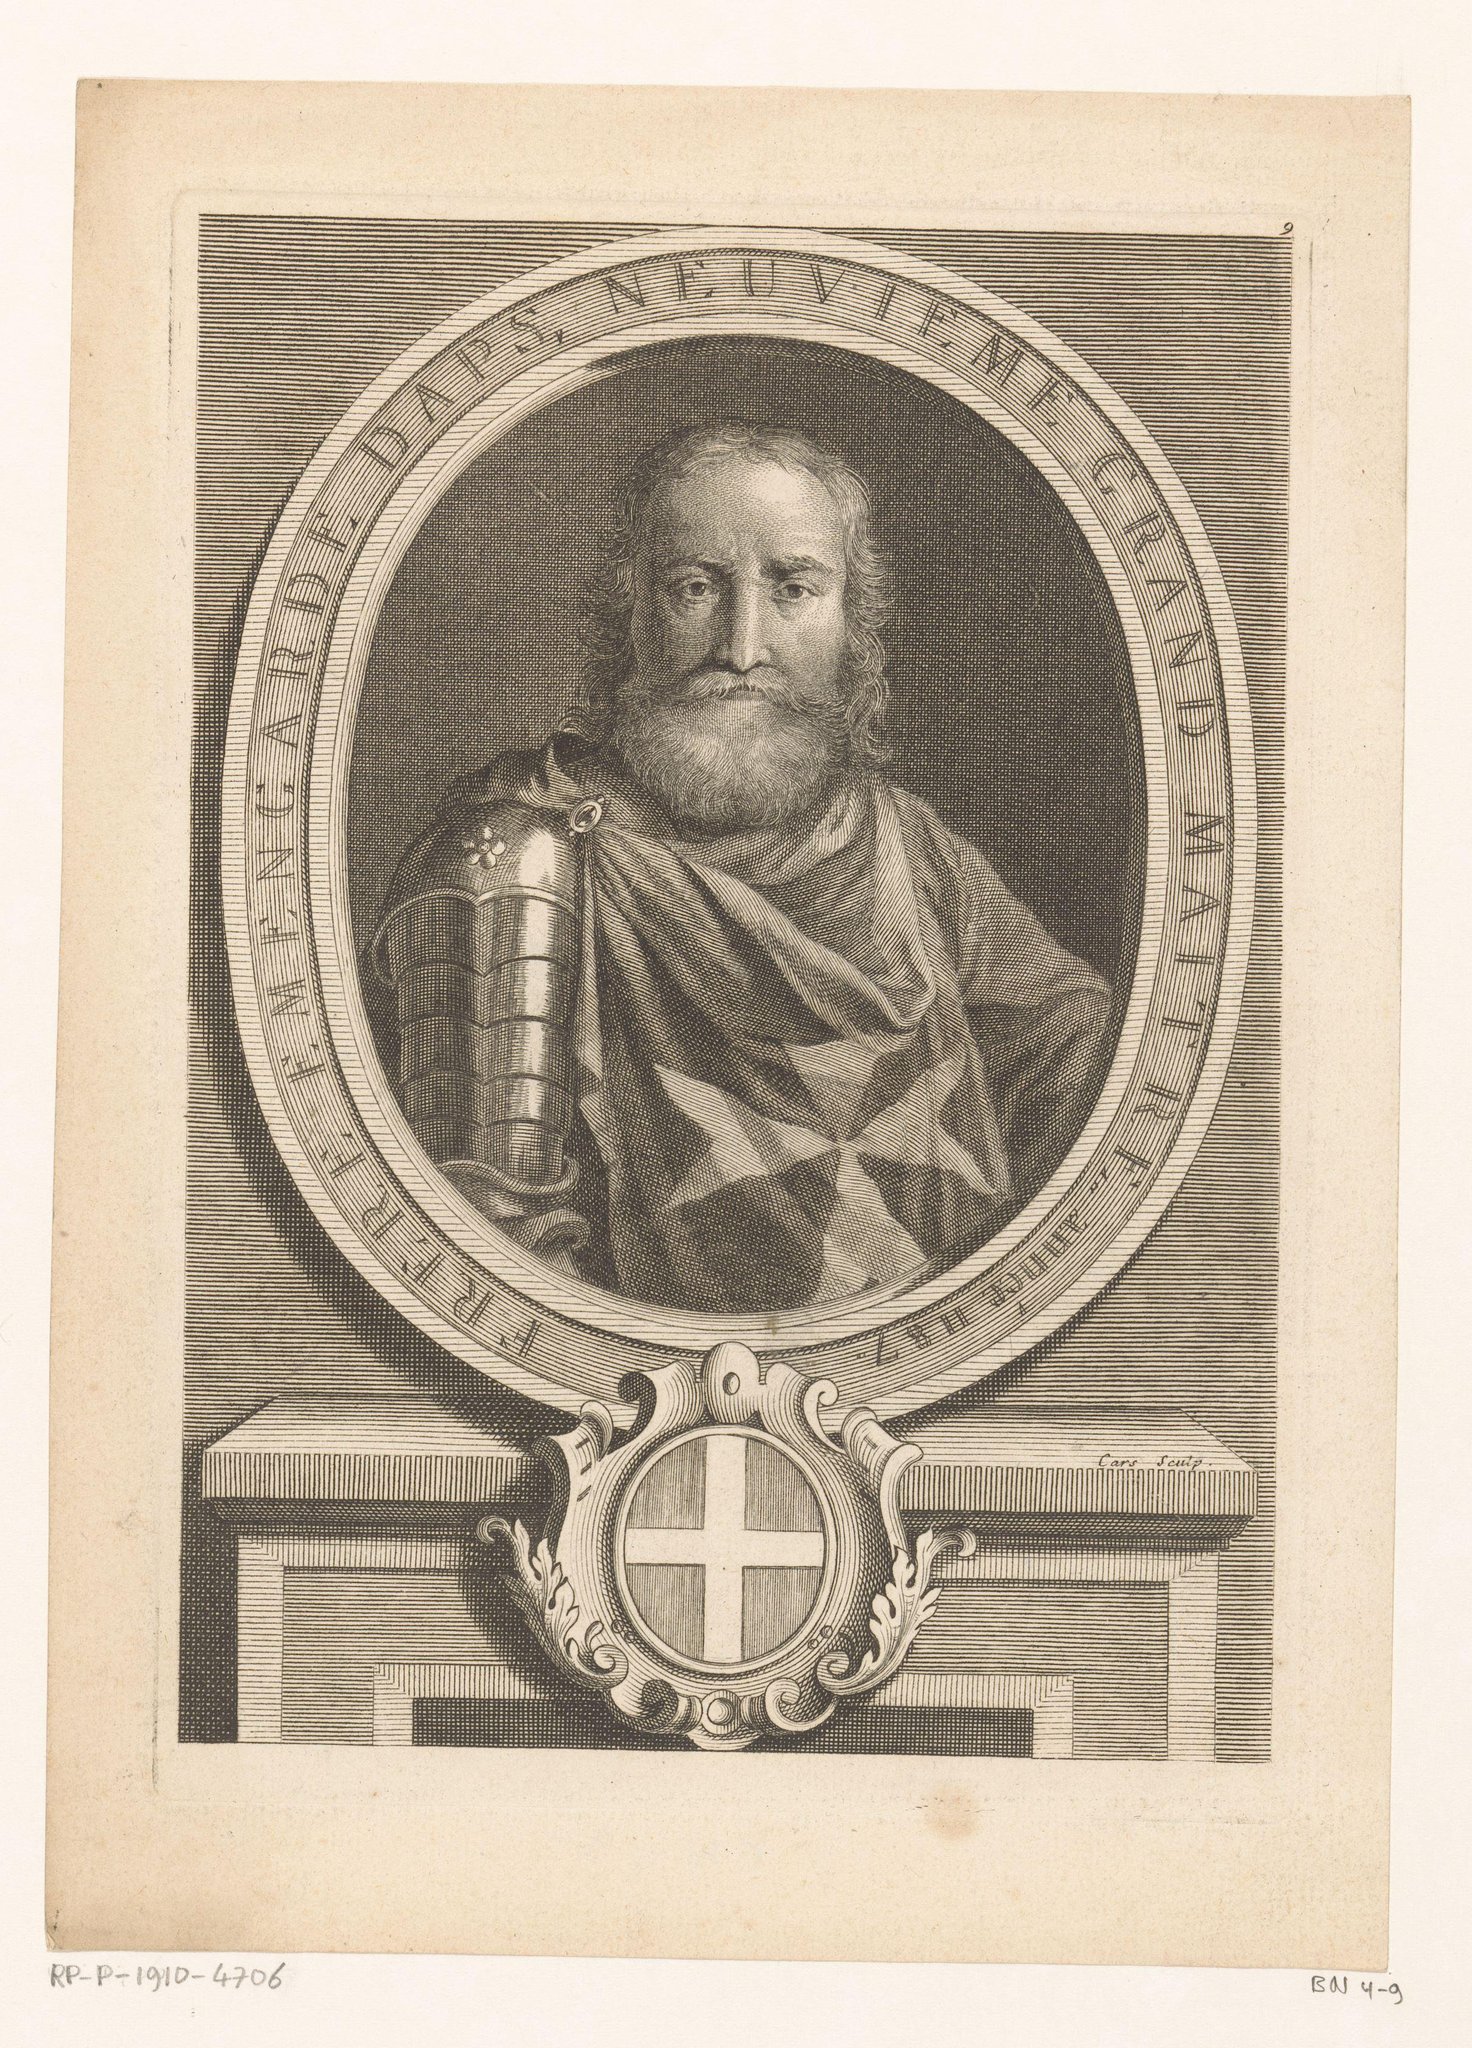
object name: book illustration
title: Portret van Hermangard d'Asp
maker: laurent cars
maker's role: print maker, publisher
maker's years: 1699-1771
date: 1726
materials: paper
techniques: engraving, etching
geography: france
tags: historical persons, military orders, e.g.: knights templars, knights of malta, teutonic knights ~ roman catholic church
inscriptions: collector's mark: Lugt 2228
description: Prent uit: Vertot, René Aubert de. Histoire des Chevaliers hospitaliers de St Jean de Jérusalem. Parijs: Rollin, Quillau, Desaint, 1726. Illustratie op p. 213 van deel 1. Cars vervaardigde portretten van 65 grootmeesters van de Maltezer Orde.